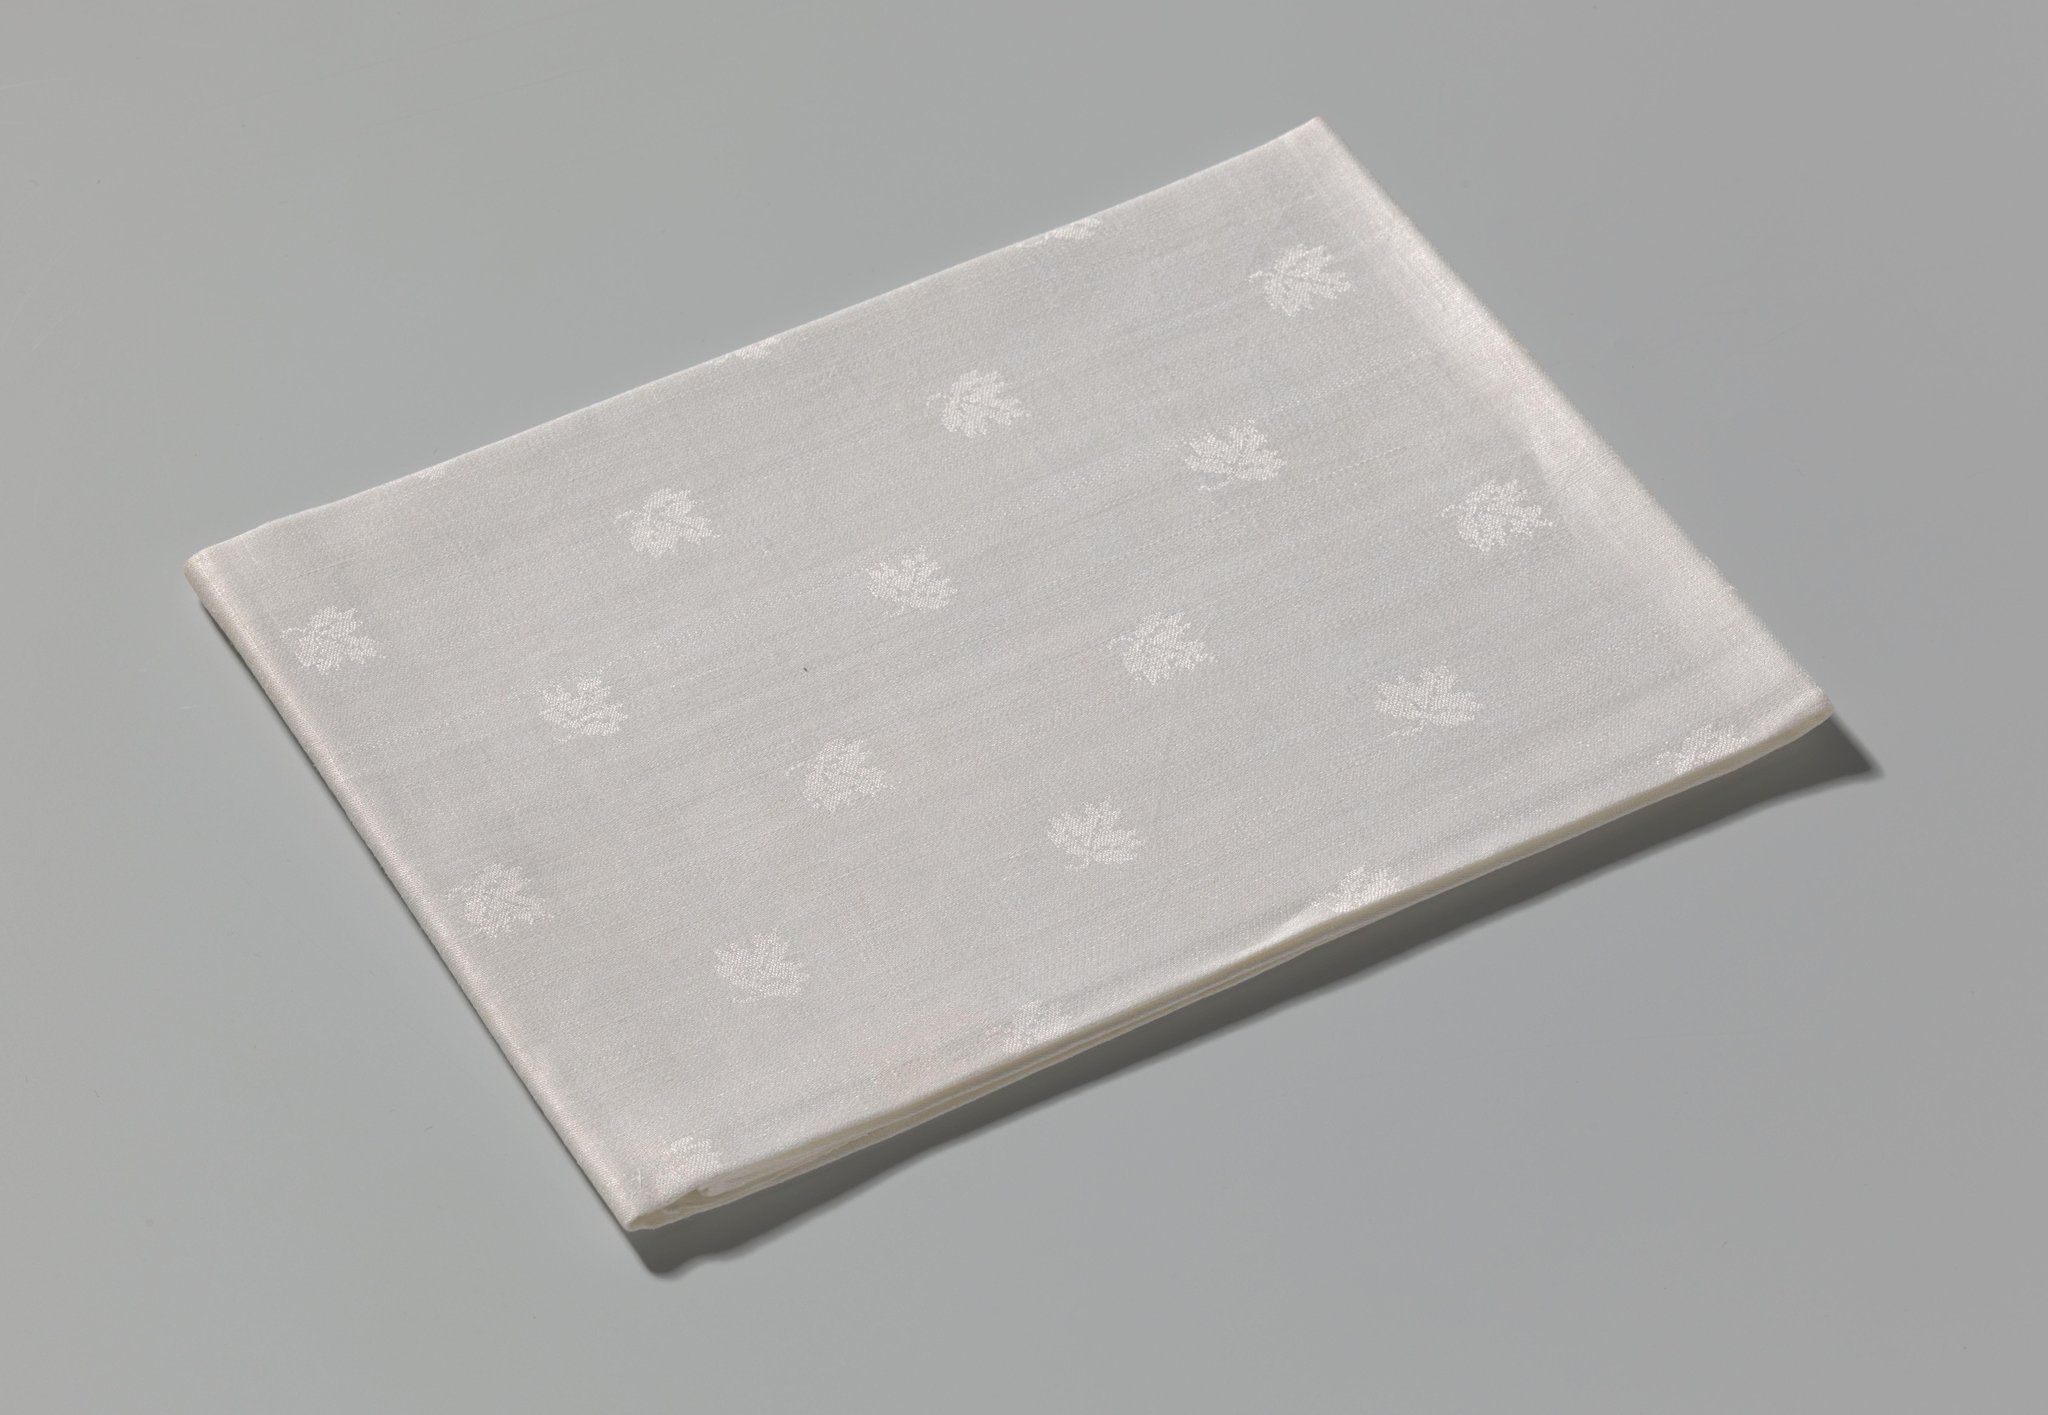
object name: napkin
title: Servet van wit linnendamast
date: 1800-1900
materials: linen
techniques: damask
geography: netherlands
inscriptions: mark: ‘twee palmtakken, waarbinnen de gekroonde initialen CB en 25’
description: Wit linnen damasten servet. Merk twee palmtakken, waarbinnen de gekroonde initialen CB en 25.